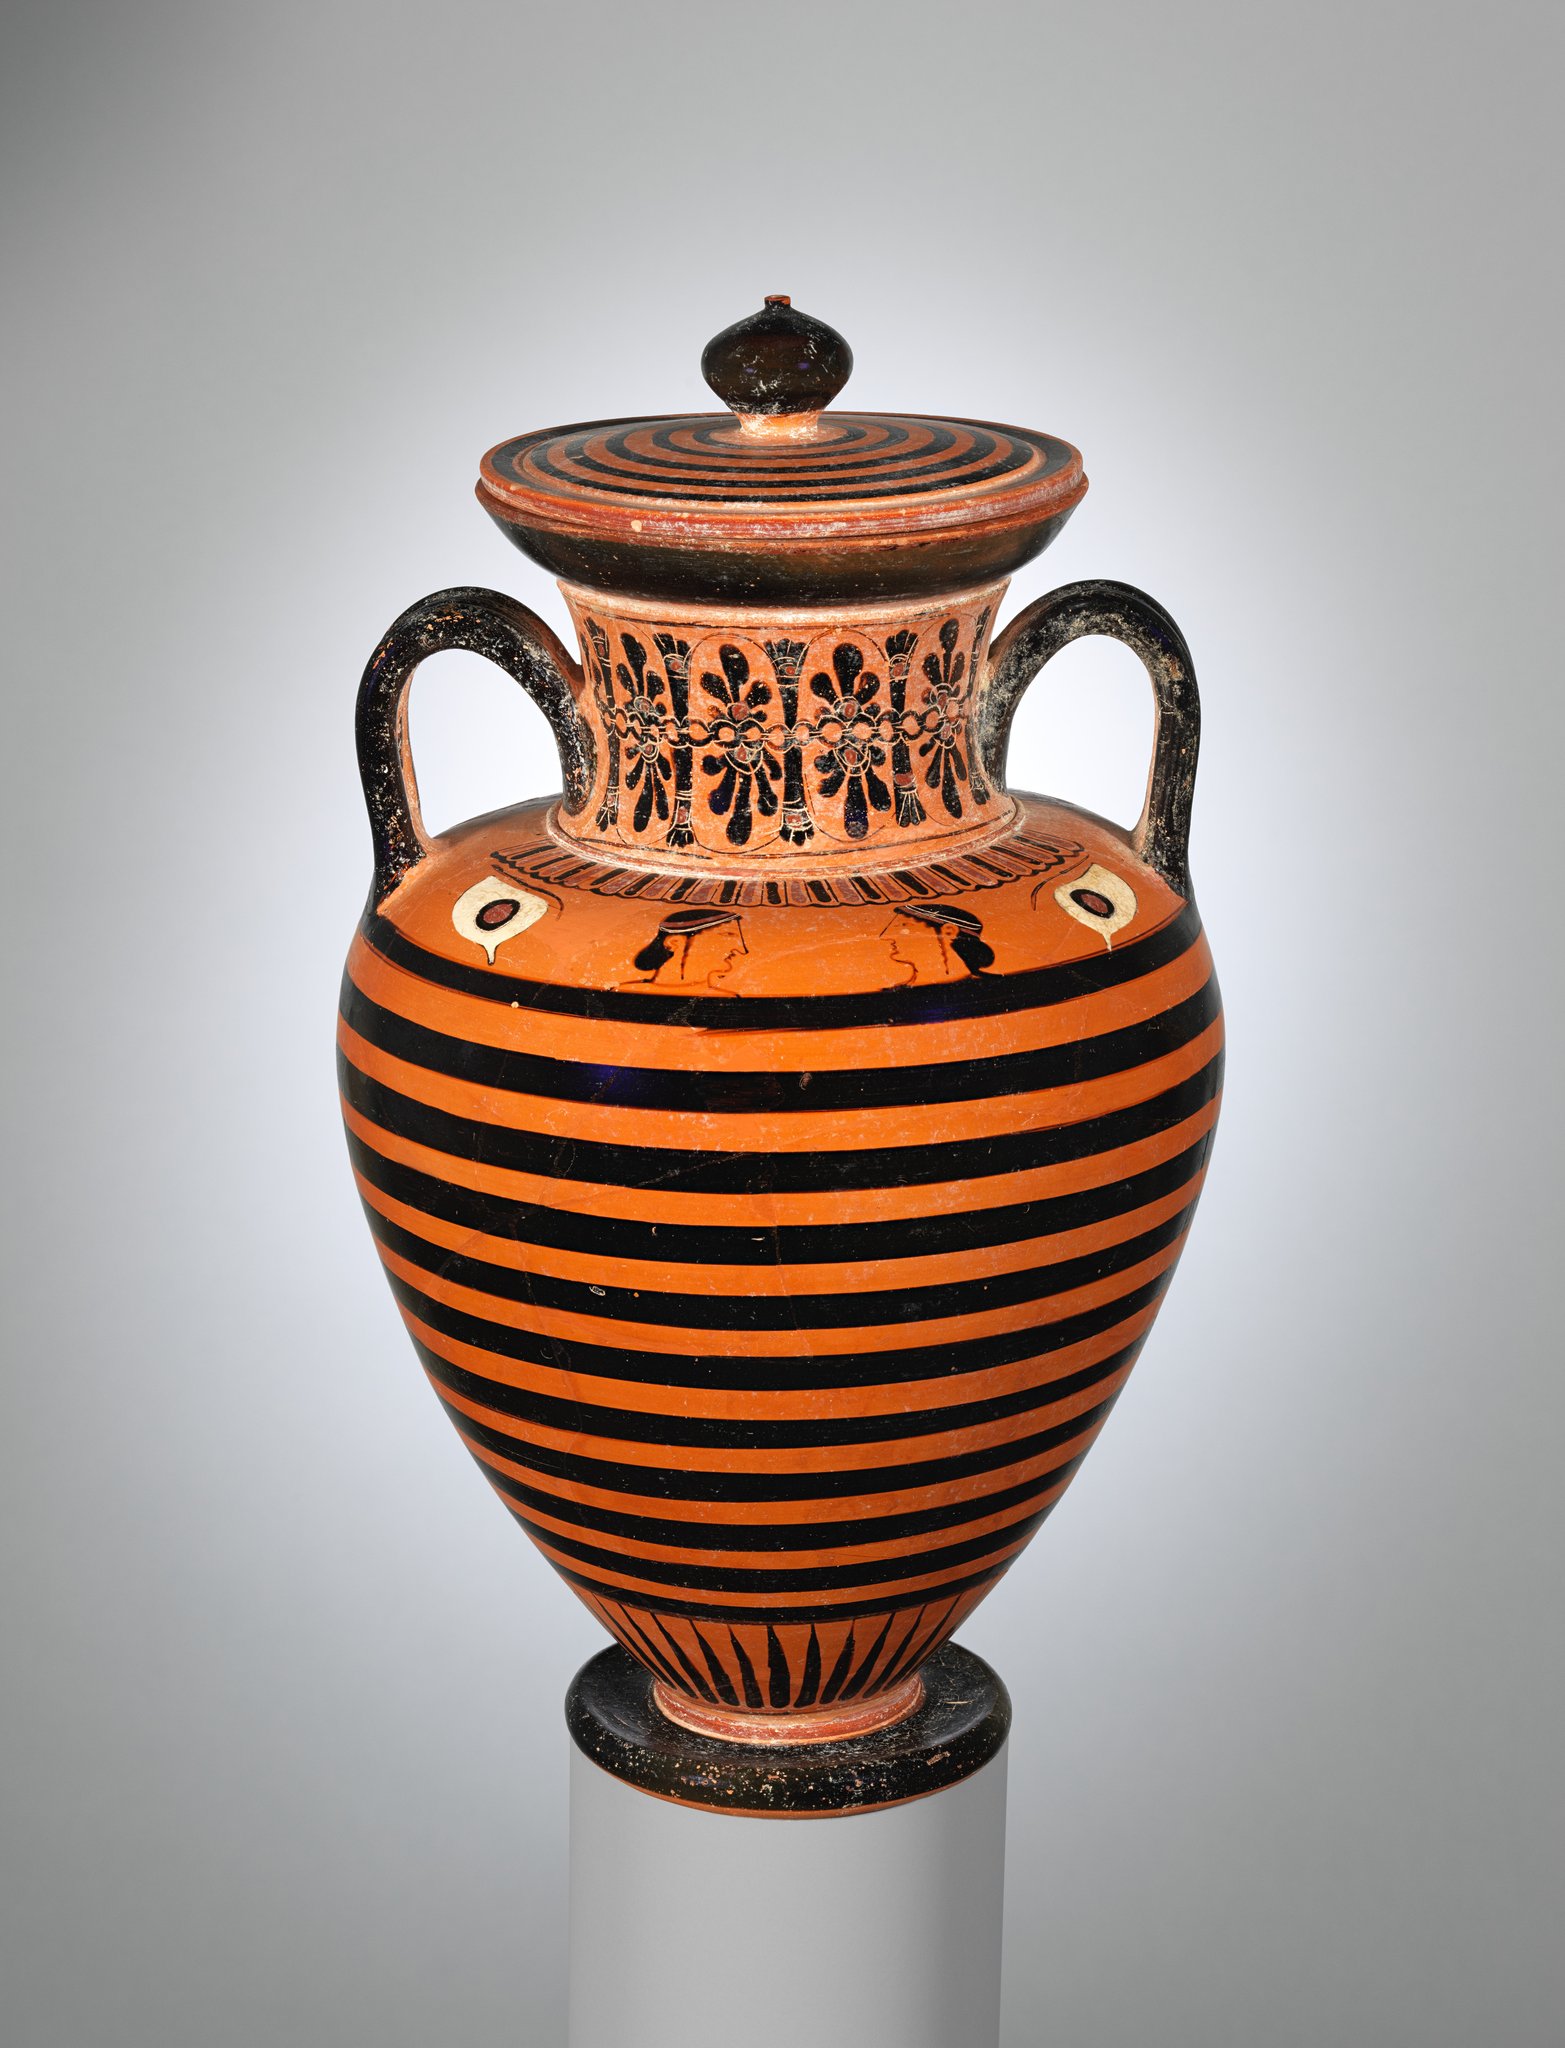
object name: neck amphora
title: Terracotta neck-amphora (jar)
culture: greek, attic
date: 520 BCE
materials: terracotta